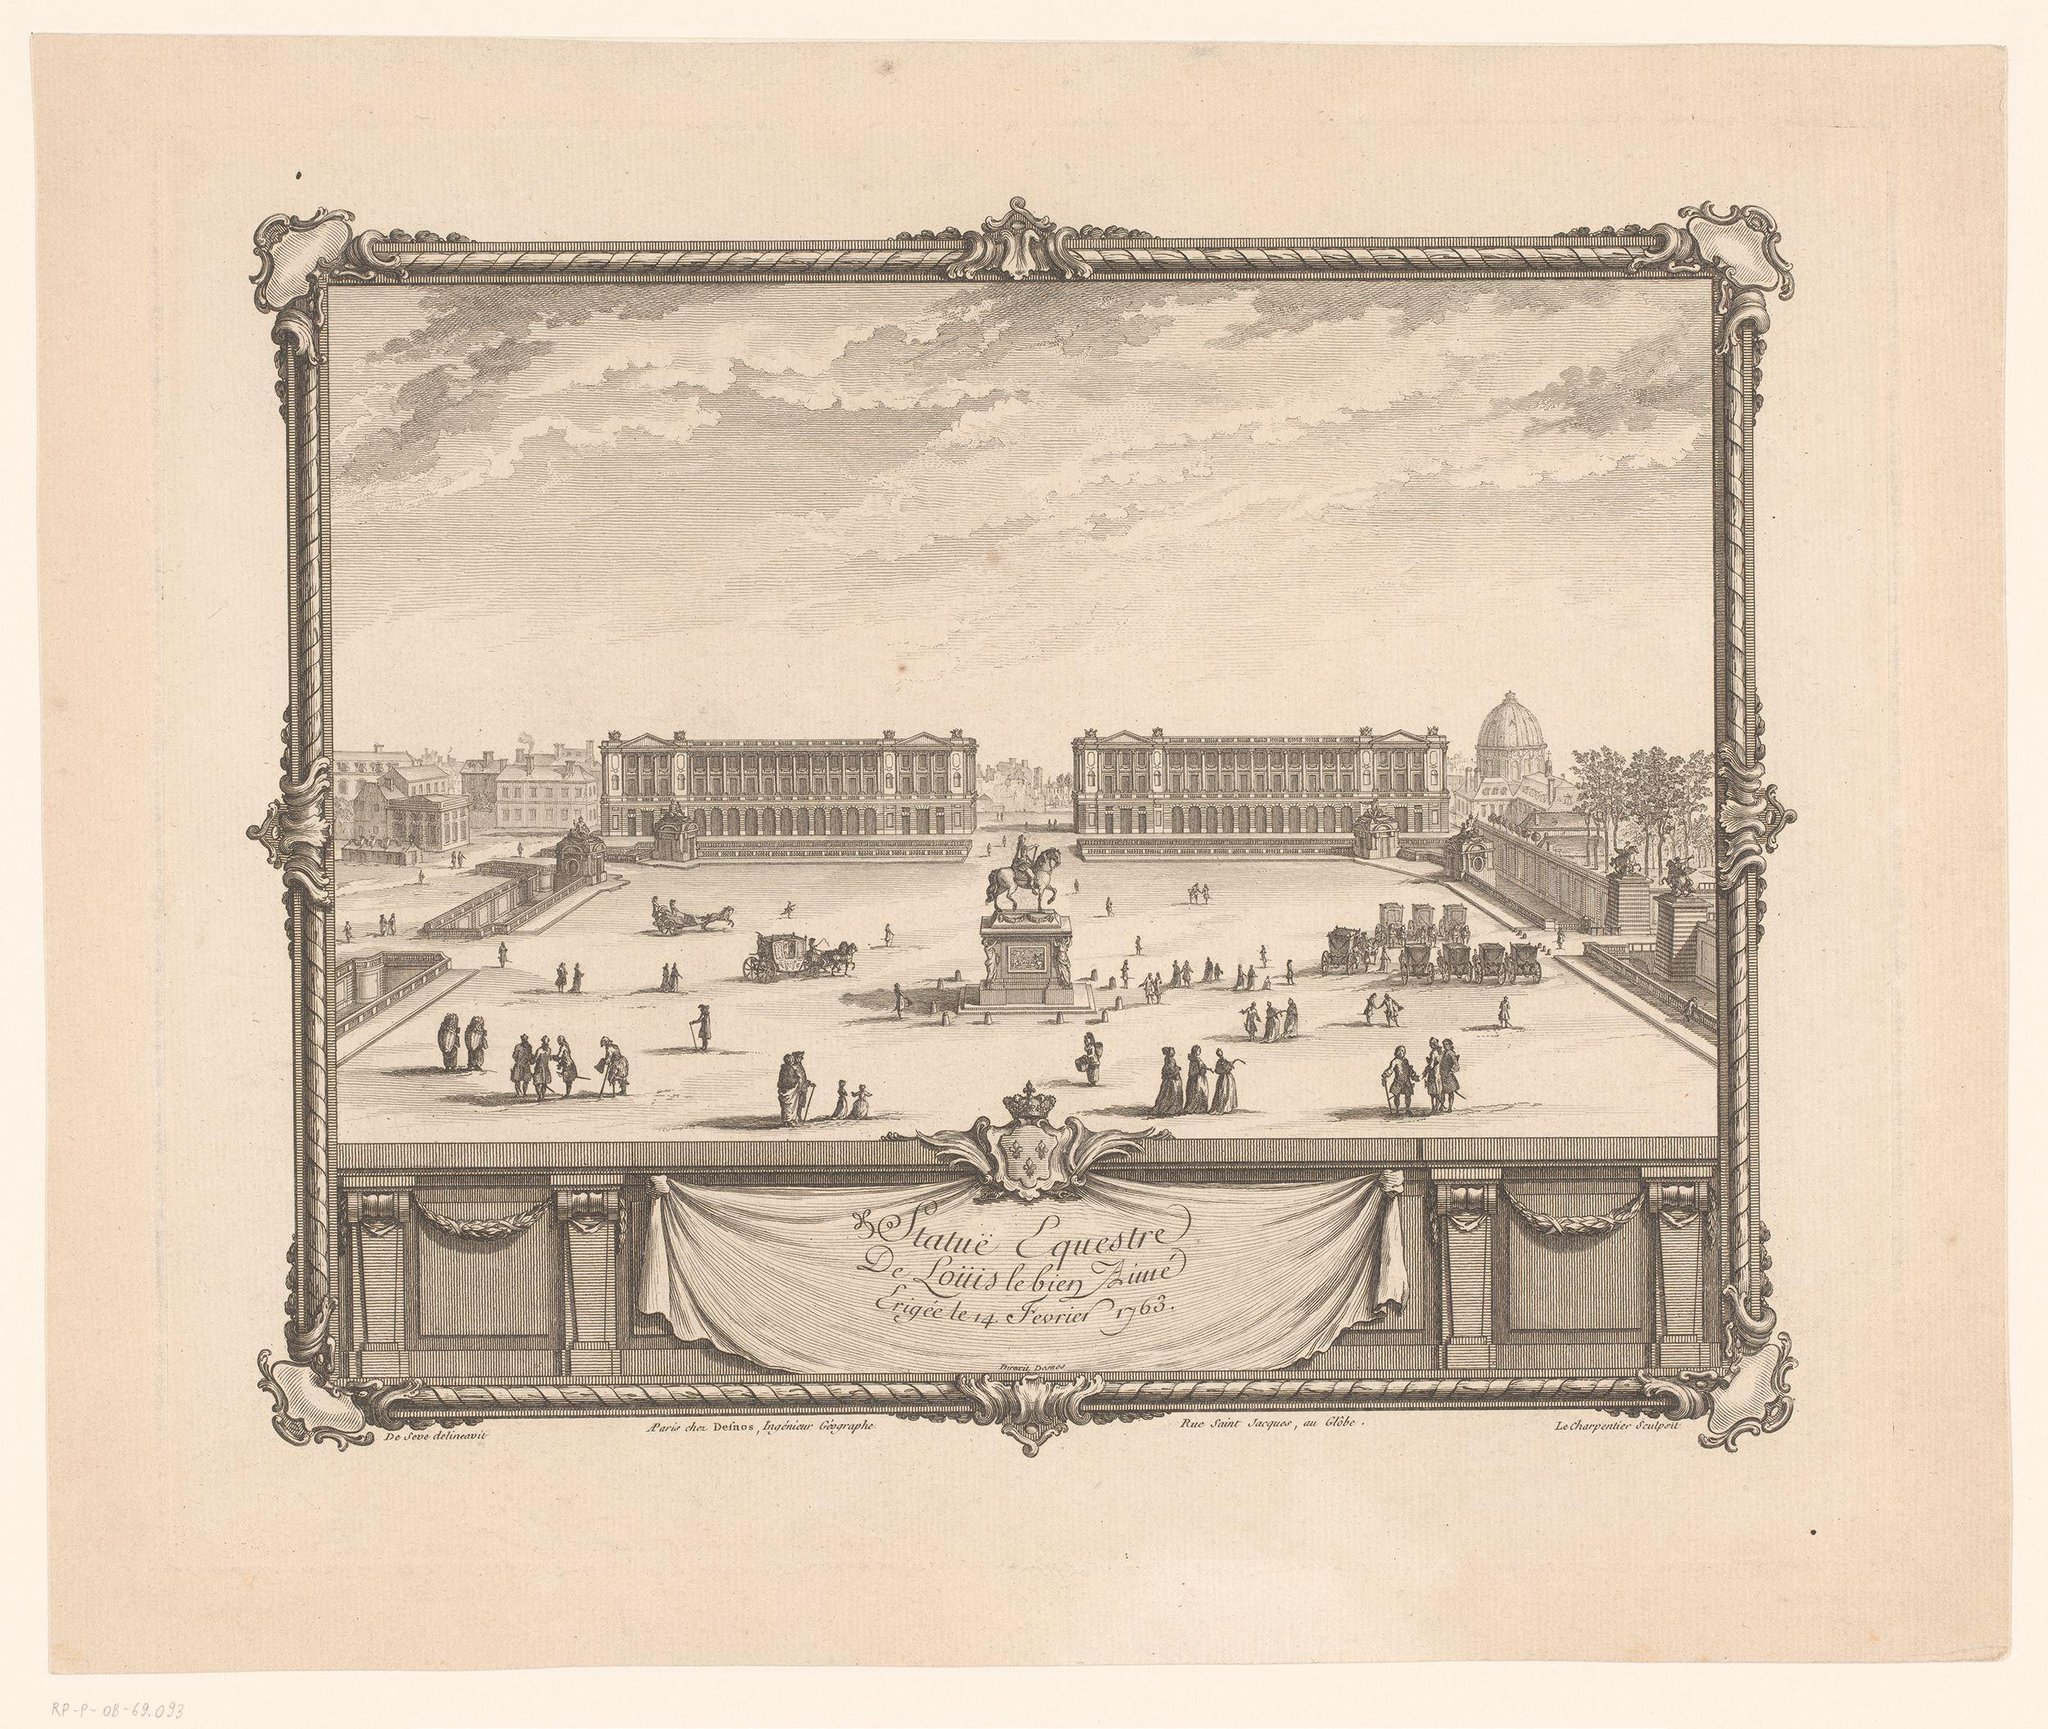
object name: print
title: Stadsgezicht met ruiterstandbeeld van Lodewijk XV van Frankrijk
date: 1764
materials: paper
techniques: engraving, etching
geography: paris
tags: monument, statue (+ city(-scape) with figures, staffage), equestrian statue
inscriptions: watermark, collector's mark: Lugt 2228